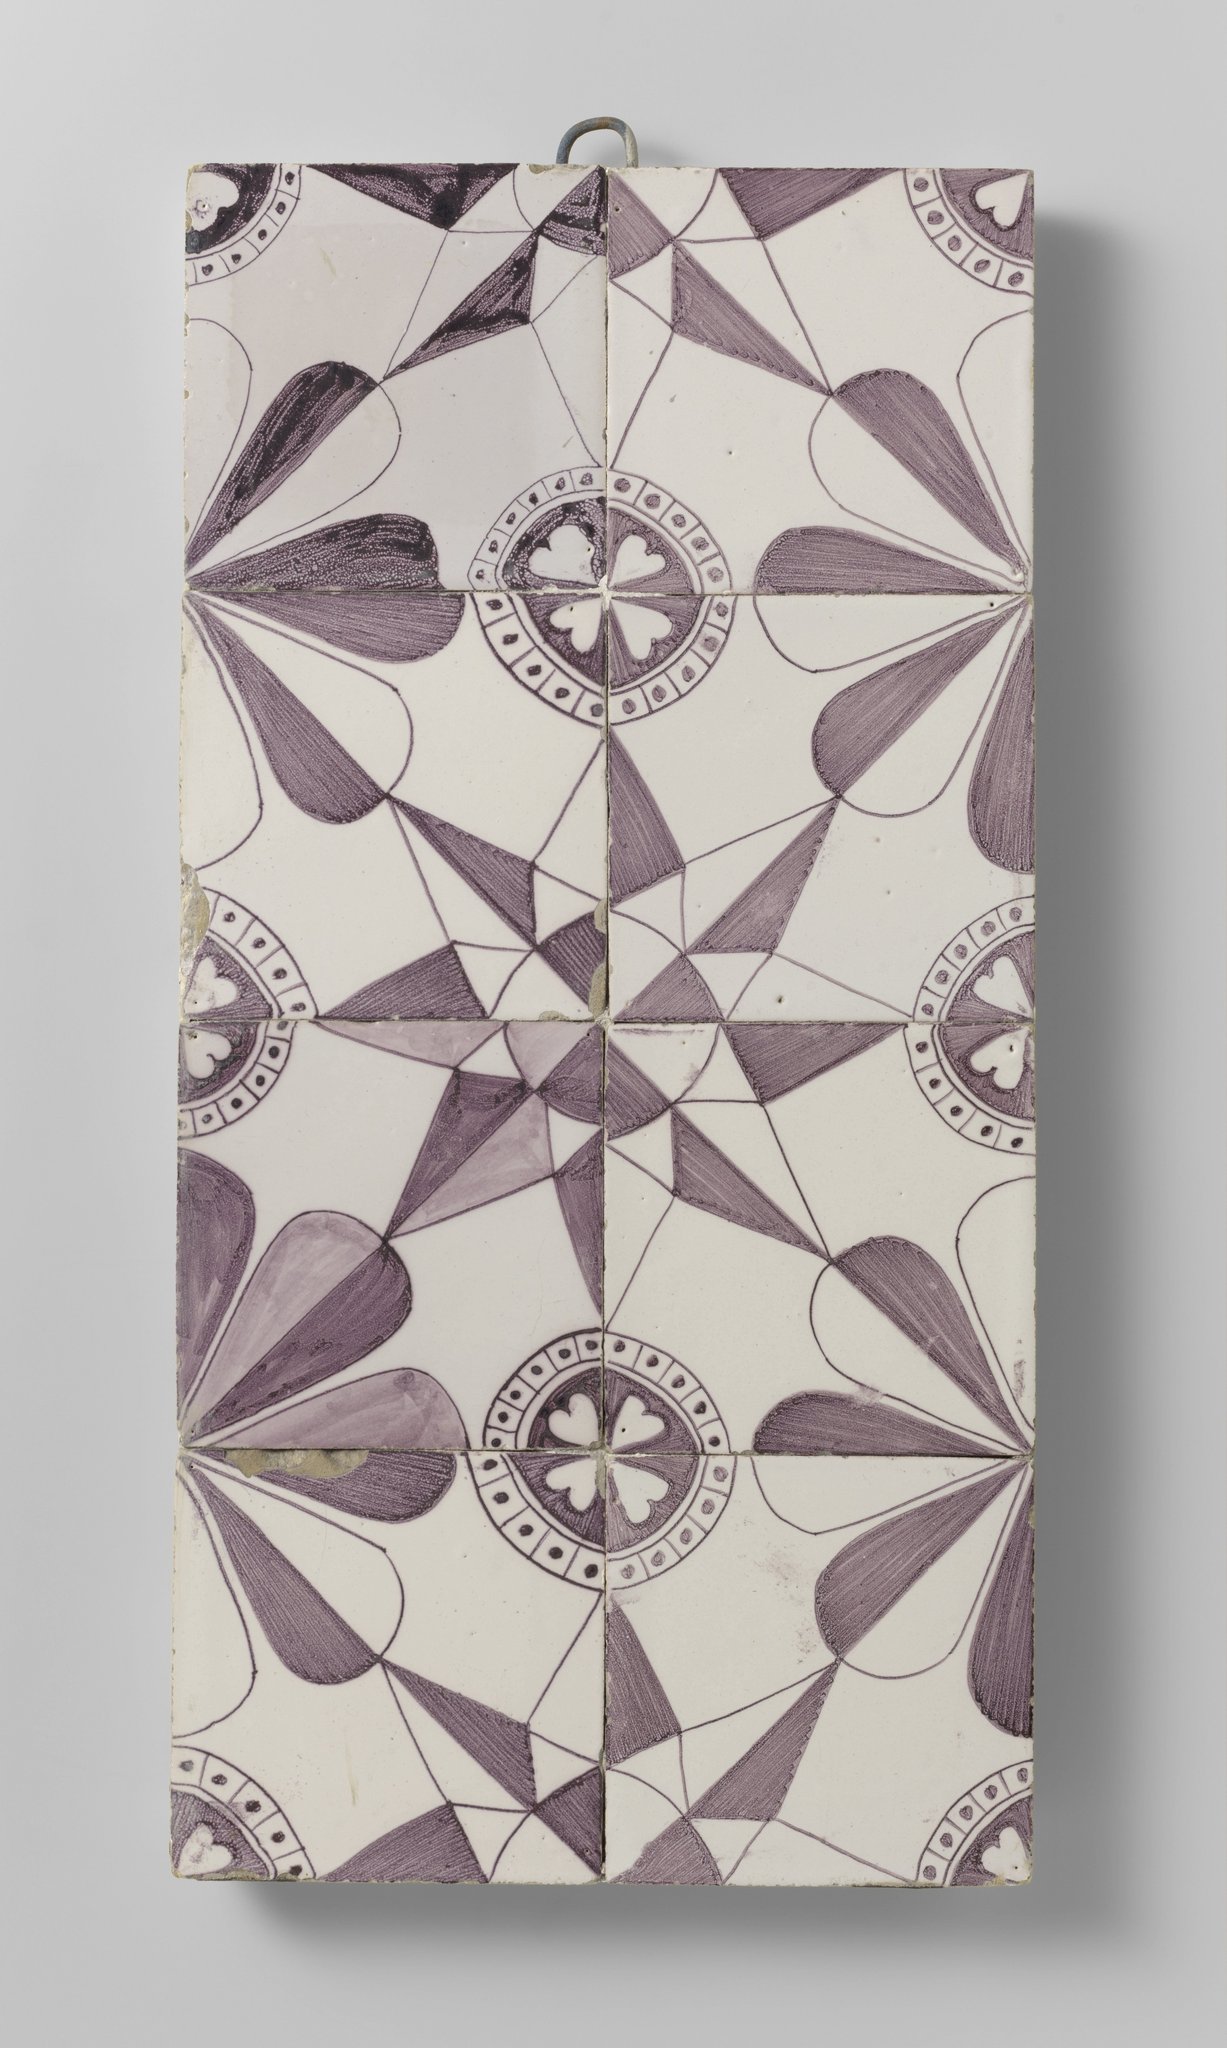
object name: tile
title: Tegelveld van acht tegels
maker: Anonymous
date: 1725-1840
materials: earthenware, glaze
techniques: maiolica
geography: netherlands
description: Tegelveld van 8 tegels (4 x 2) met een paars geschilderd geometrisch patroon van rozetten en sterren.